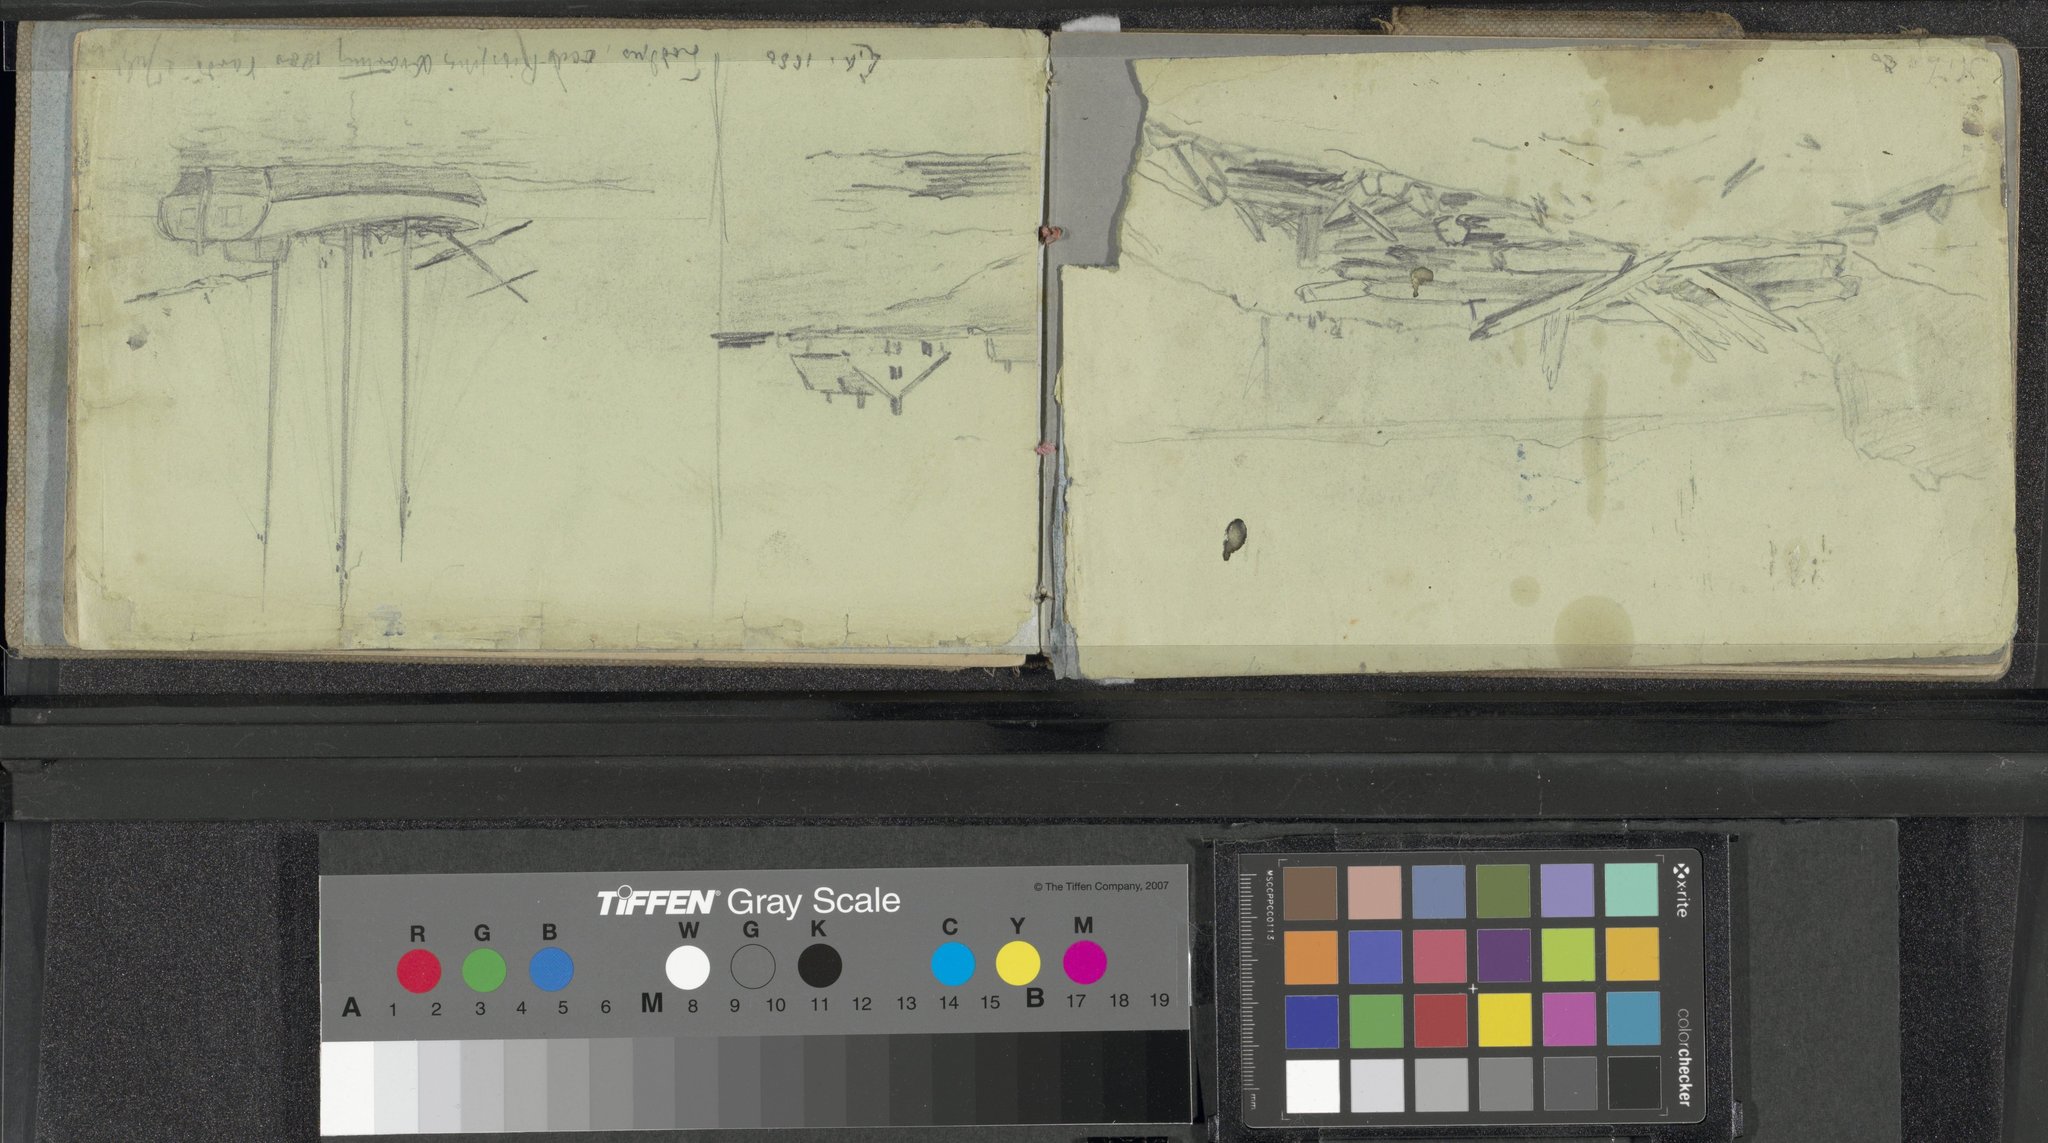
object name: sketchbook leaf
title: Wrakhout op Nova Zembla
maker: louis apol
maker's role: draughtsman, painter, print maker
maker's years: 1850-1936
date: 1880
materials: paper, pencil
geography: novaya zemlya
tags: wood, timber ~ building material, coast (in polar regions)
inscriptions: annotation: ‘N.Z. [...]’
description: Op de achtergrond de Barentszzee. Blad 7 recto uit een schetsboek met 35 bladen betekend tijdens de expeditie naar Nova Zembla in 1880.